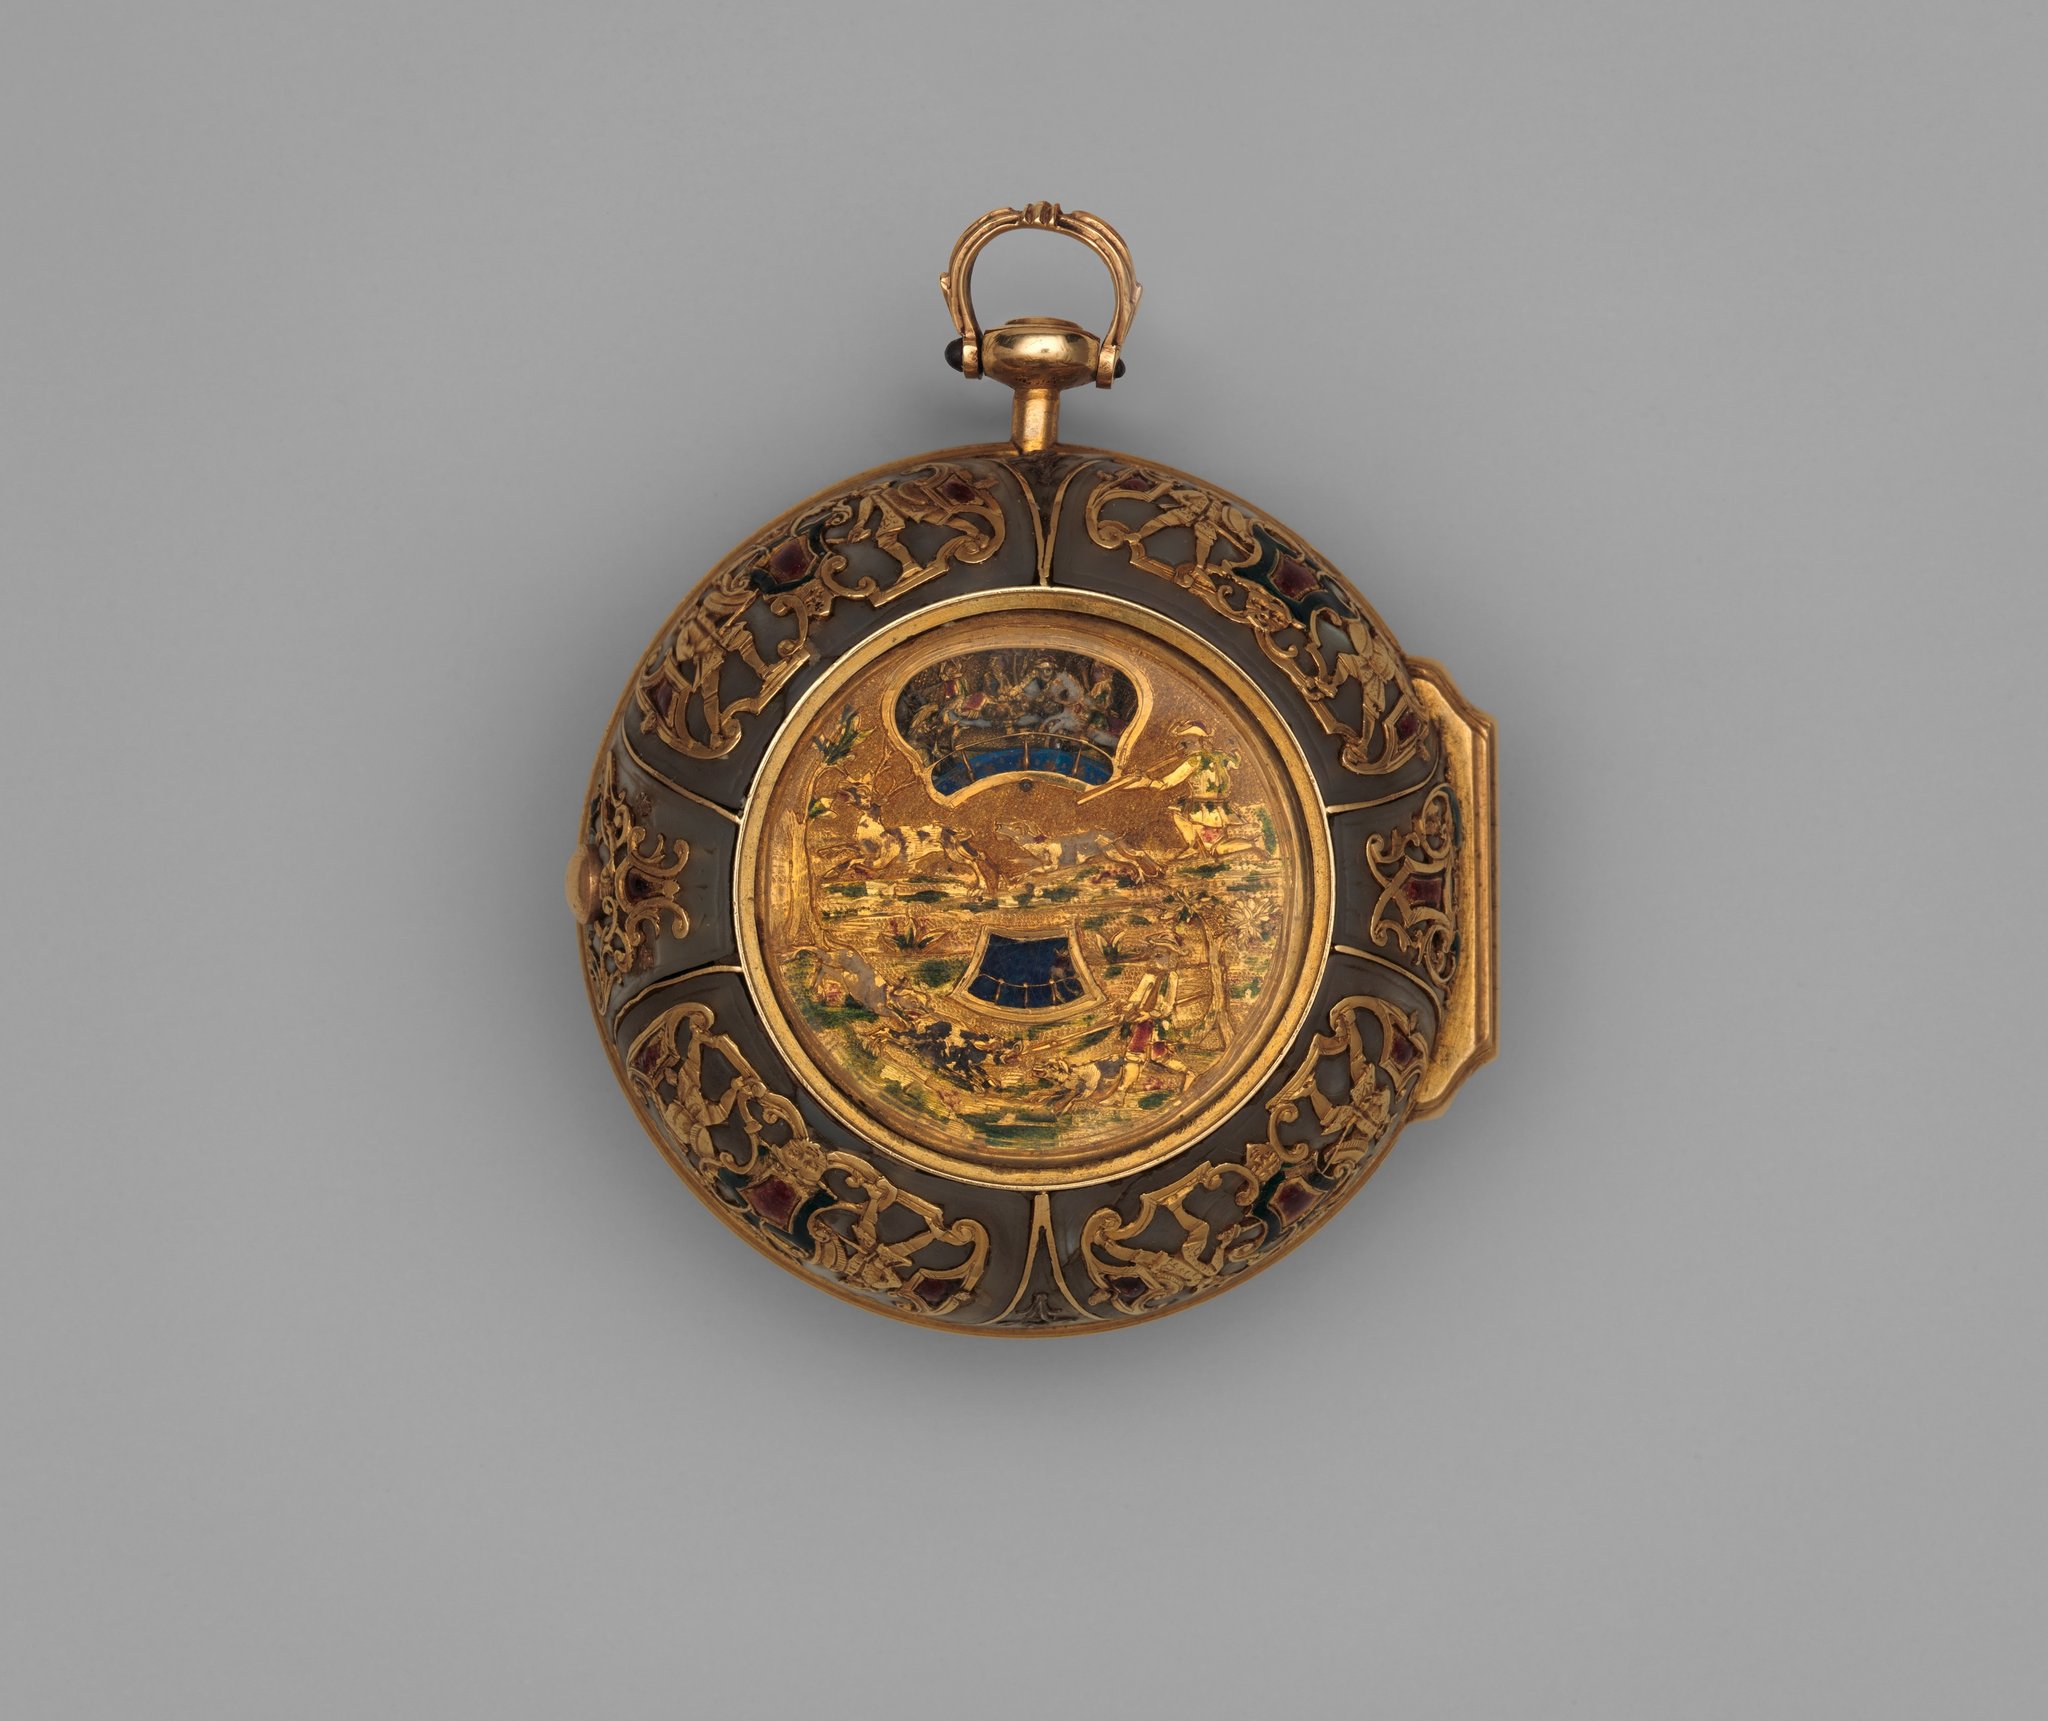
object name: watch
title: Mechanical watch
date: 1710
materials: enamel, gold, mother of pearl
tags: men,hunting,deer